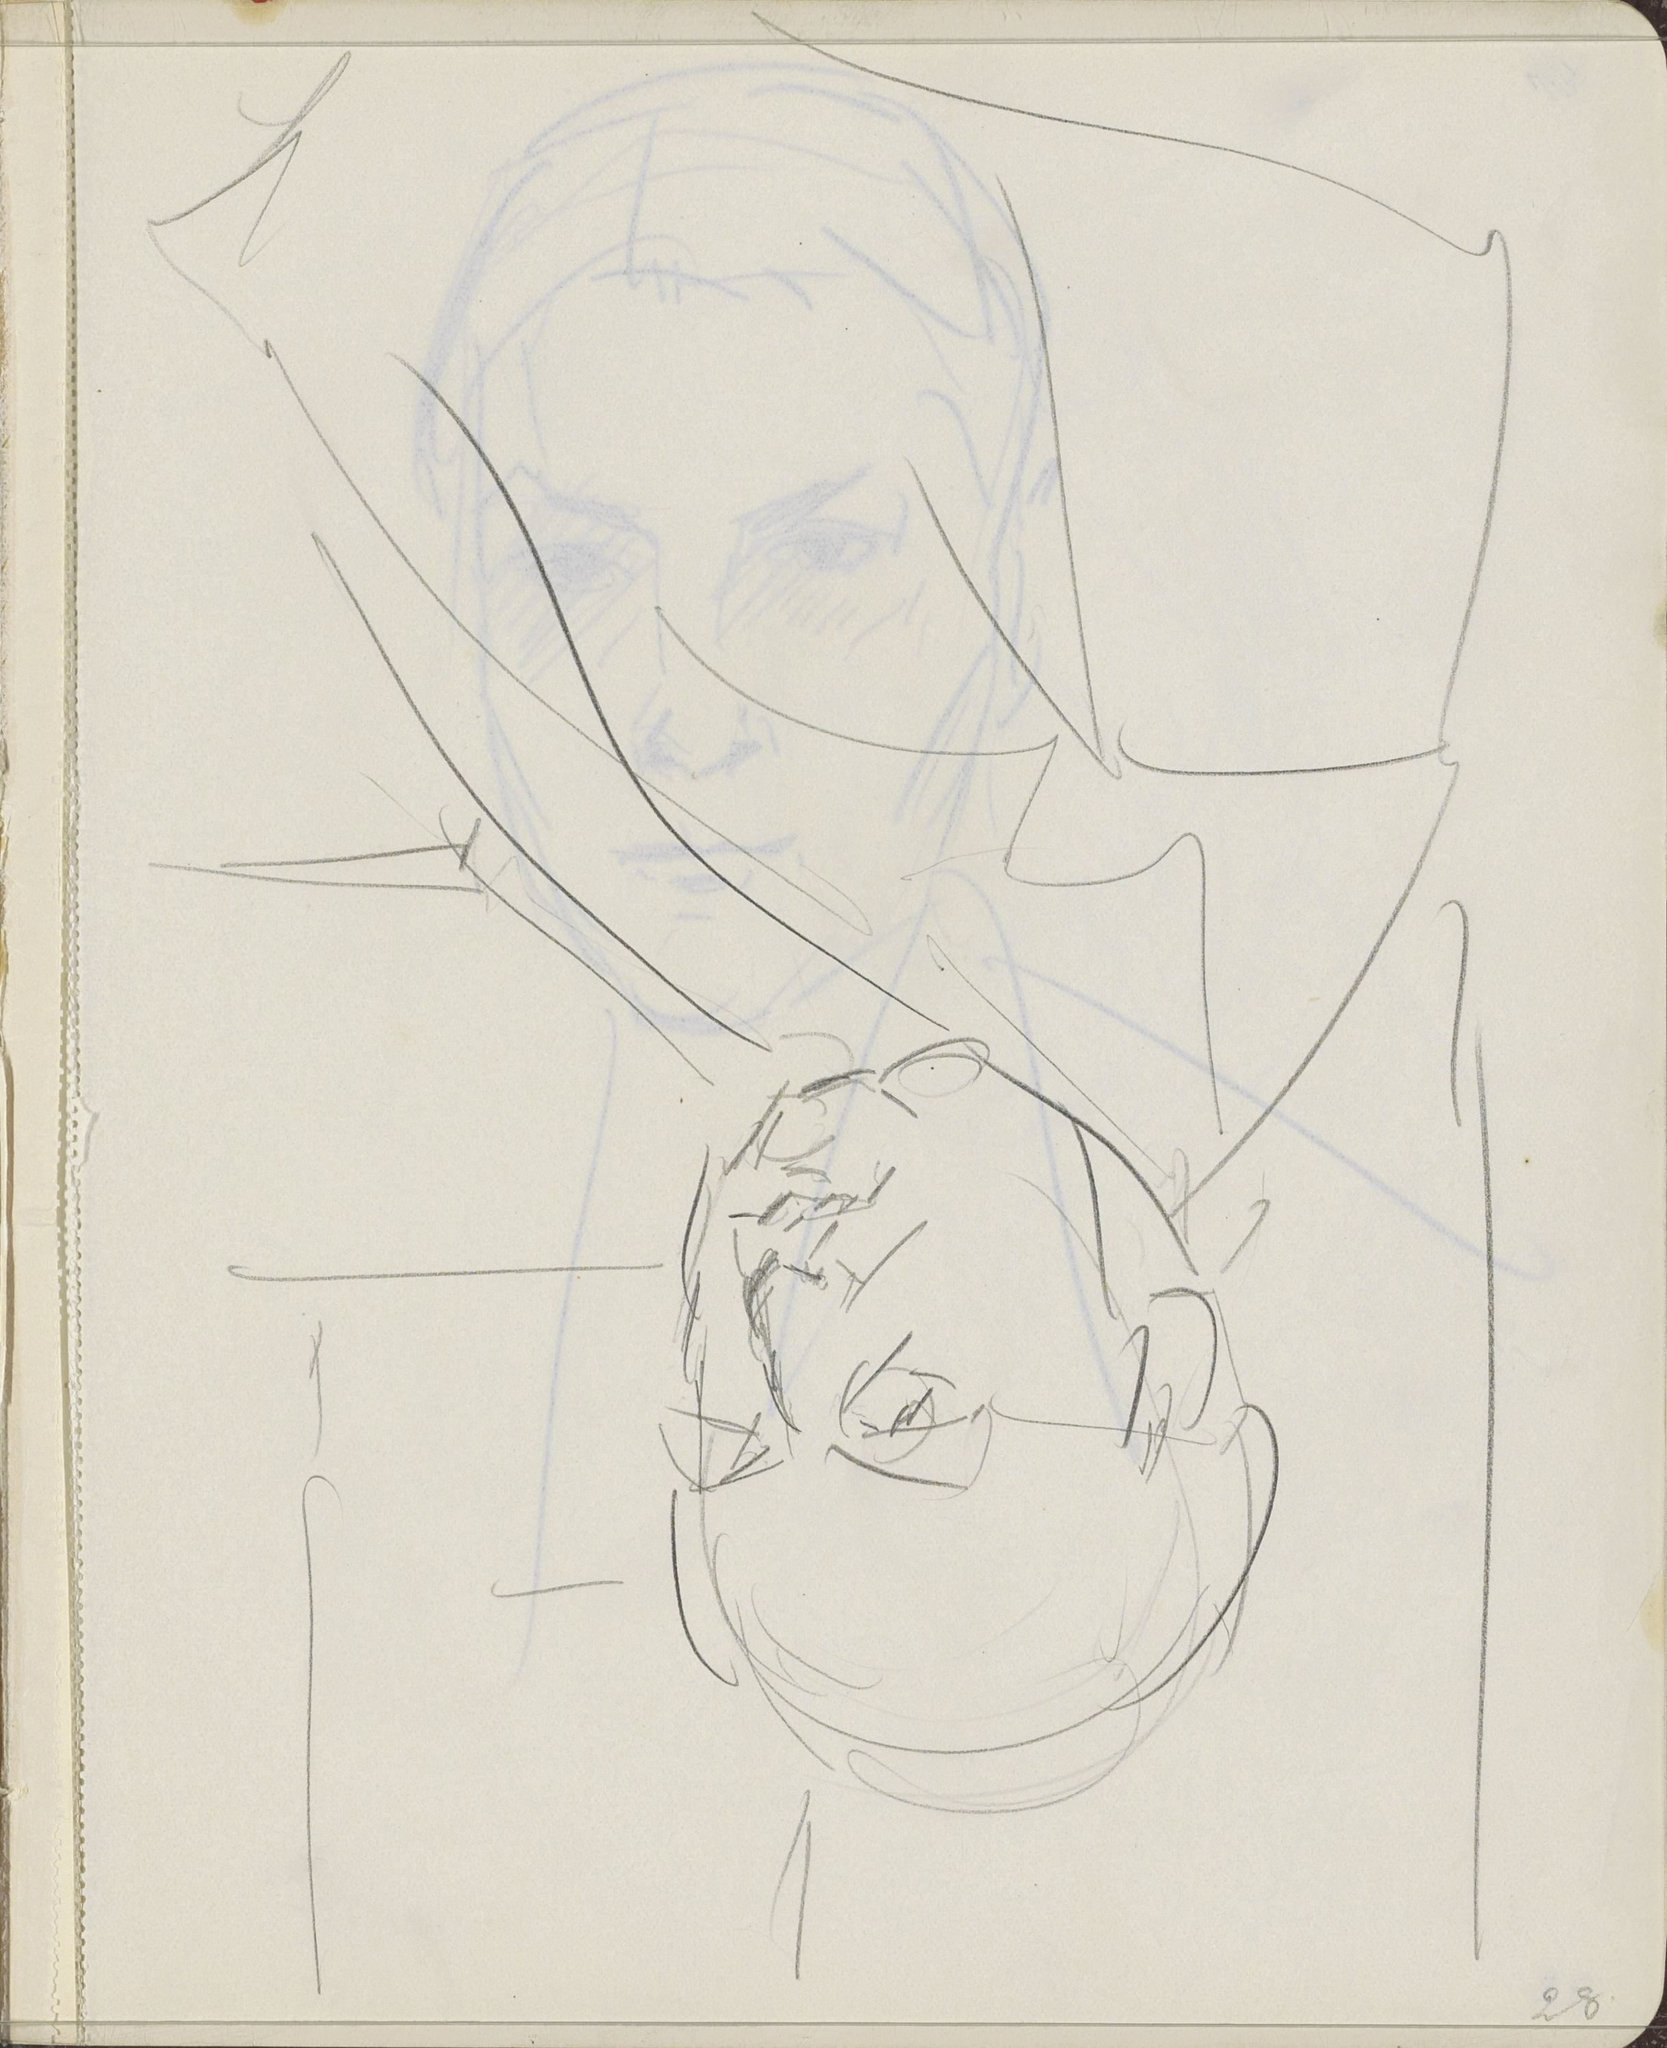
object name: sketchbook leaf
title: Zittende man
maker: isaac israels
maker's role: draughtsman, painter, print maker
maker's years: 1865-1934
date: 1925-1934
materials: paper, pencil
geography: the hague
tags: adult man (+ sitting)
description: Blad 28 recto uit schetsboek XXVI met 35 bladen.